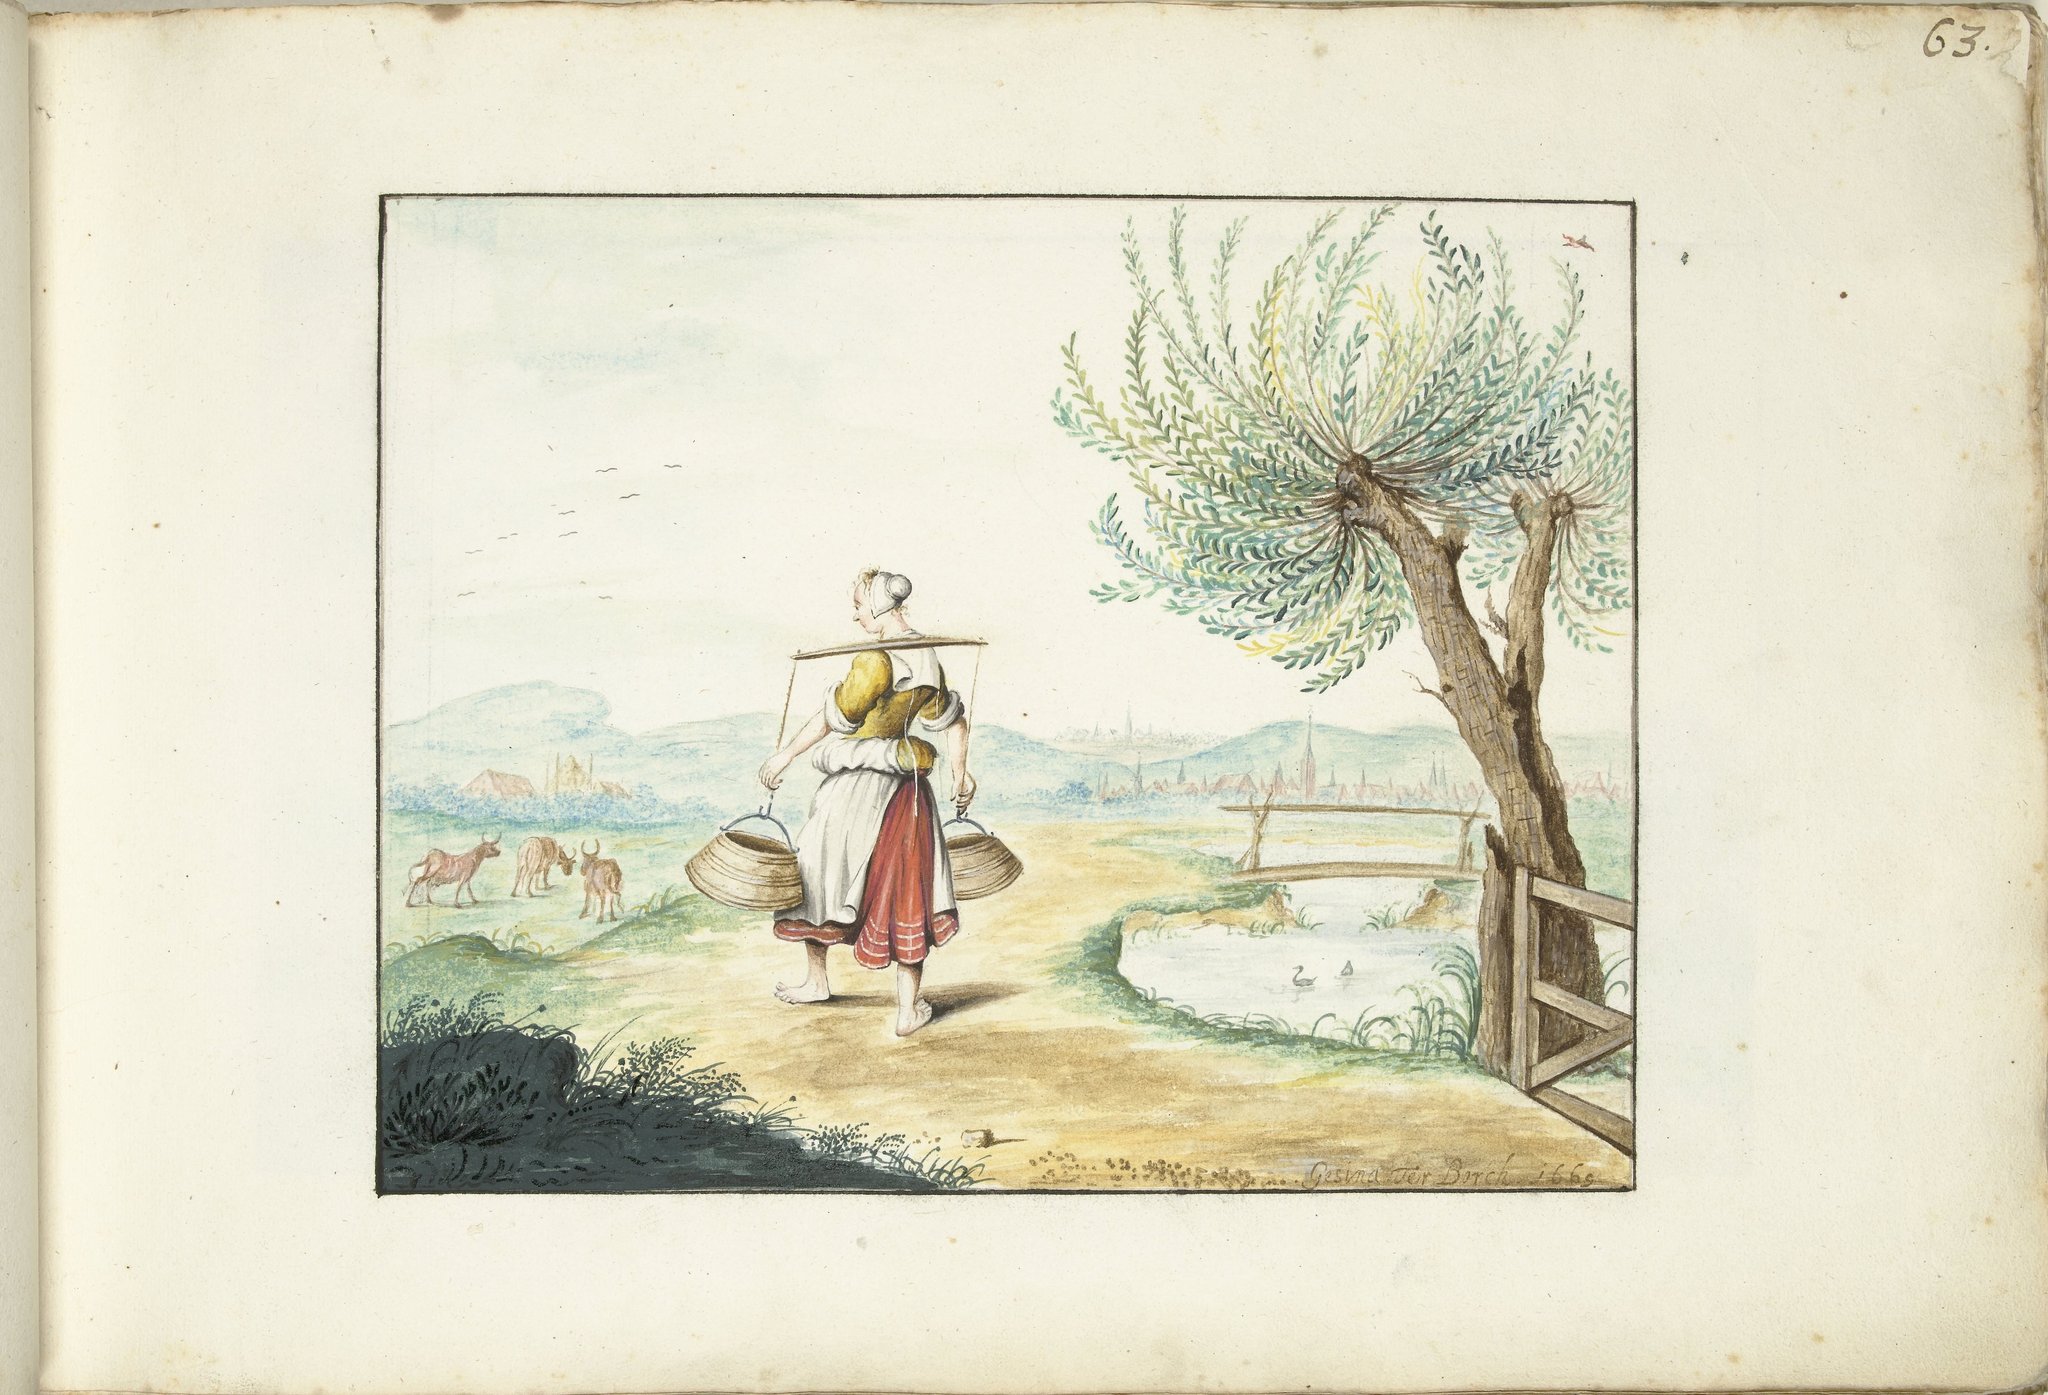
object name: watercolor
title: De melkmeid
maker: gesina ter borch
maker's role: draughtsman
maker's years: 1633-1690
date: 1669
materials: paper, watercolor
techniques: brush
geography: zwolle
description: Gesina heeft de melkmeid herhaald die ze al eerder tekende in 1654 (zie folio 106).